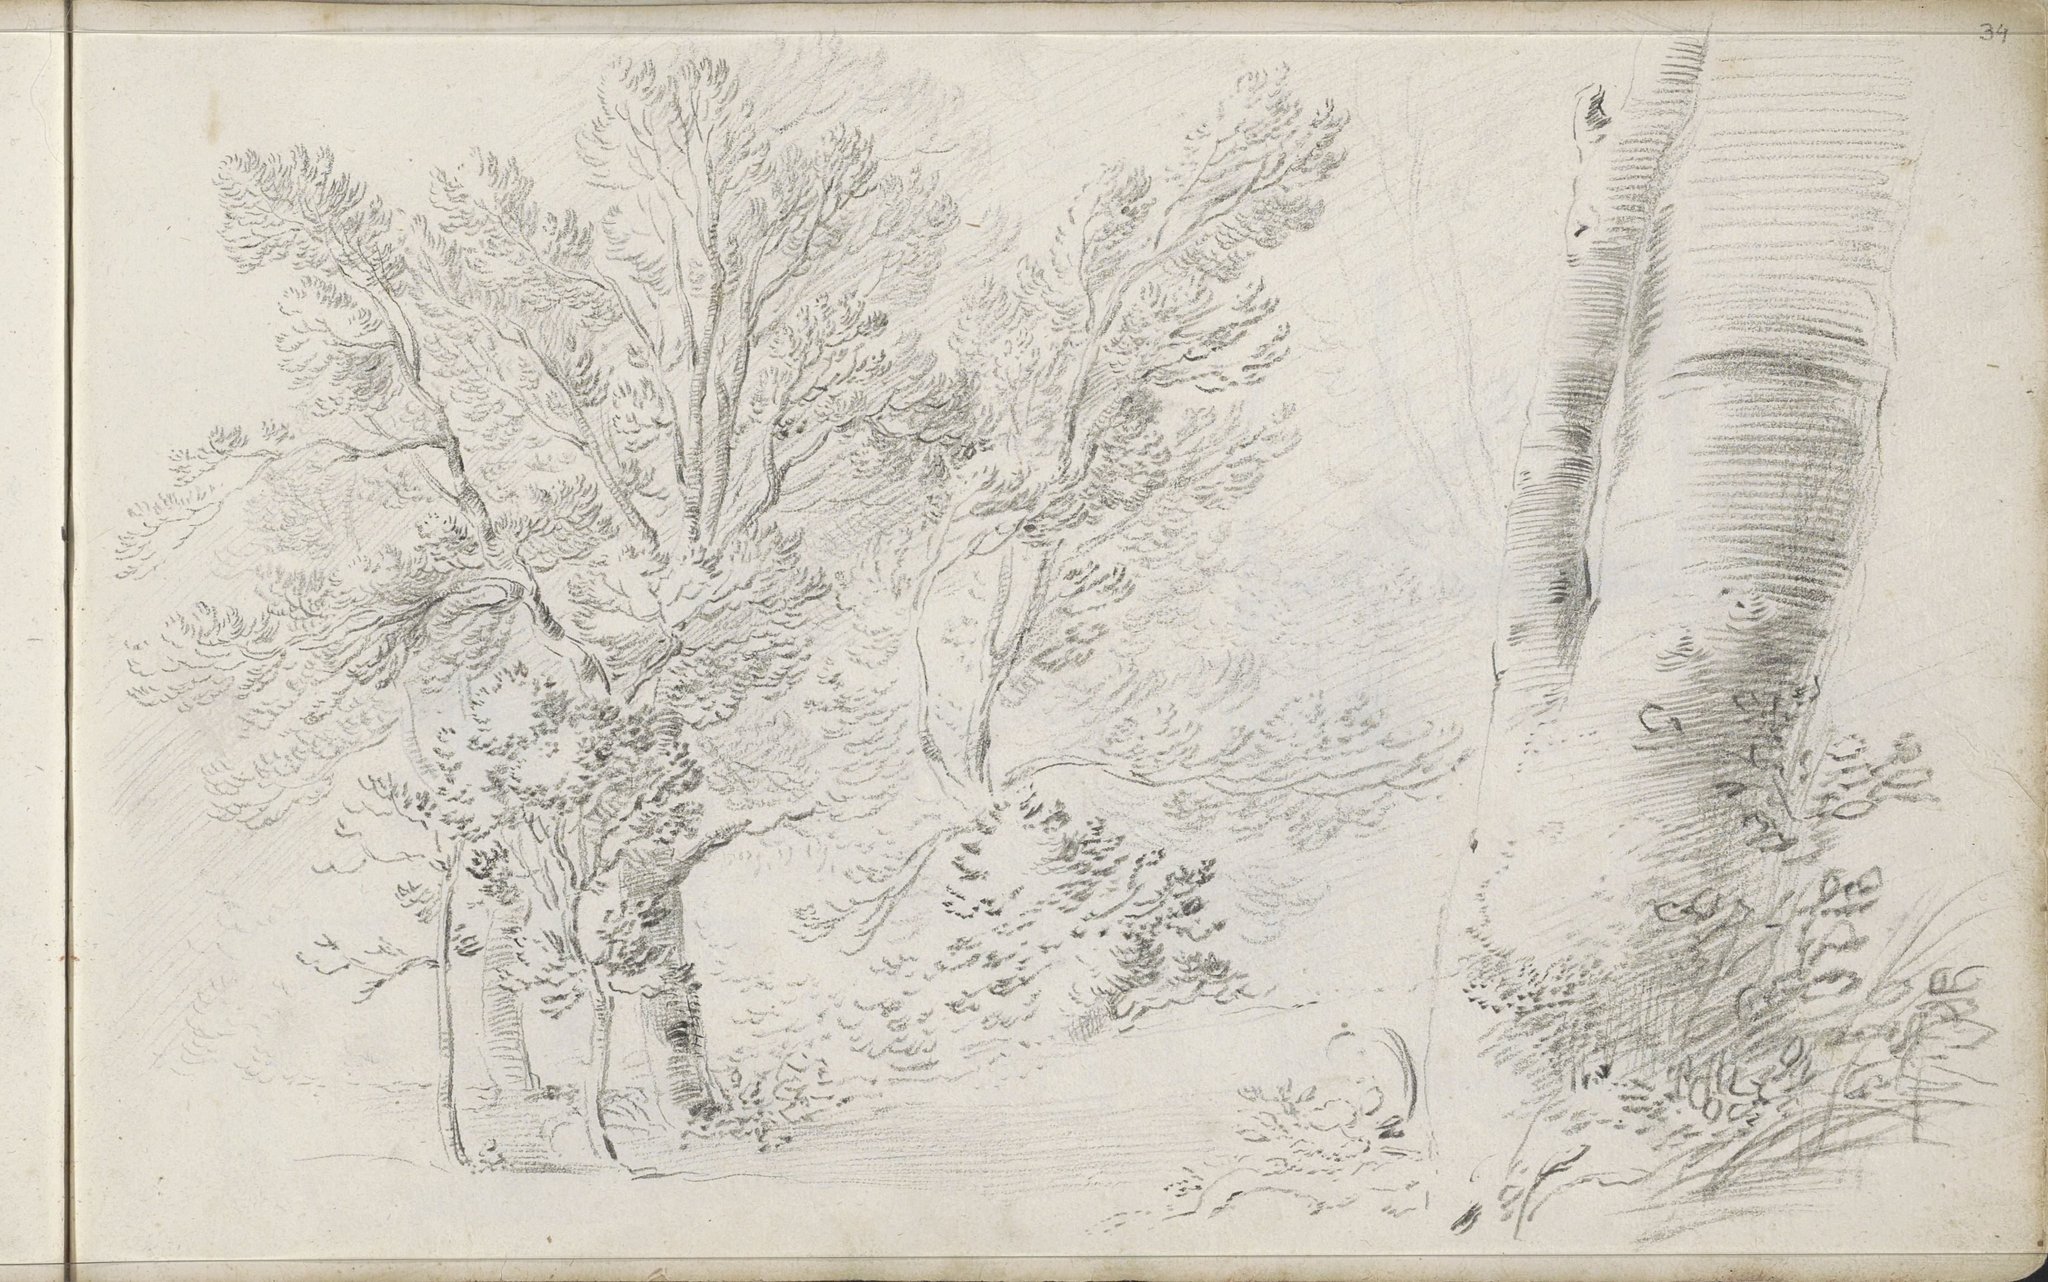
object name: sketchbook leaf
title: Boslandschap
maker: pieter moninckx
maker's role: draughtsman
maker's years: 1606-1686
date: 1645-1646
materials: chalk, paper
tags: forest, wood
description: Blad 34 recto uit een schetsboek met 39 bladen.